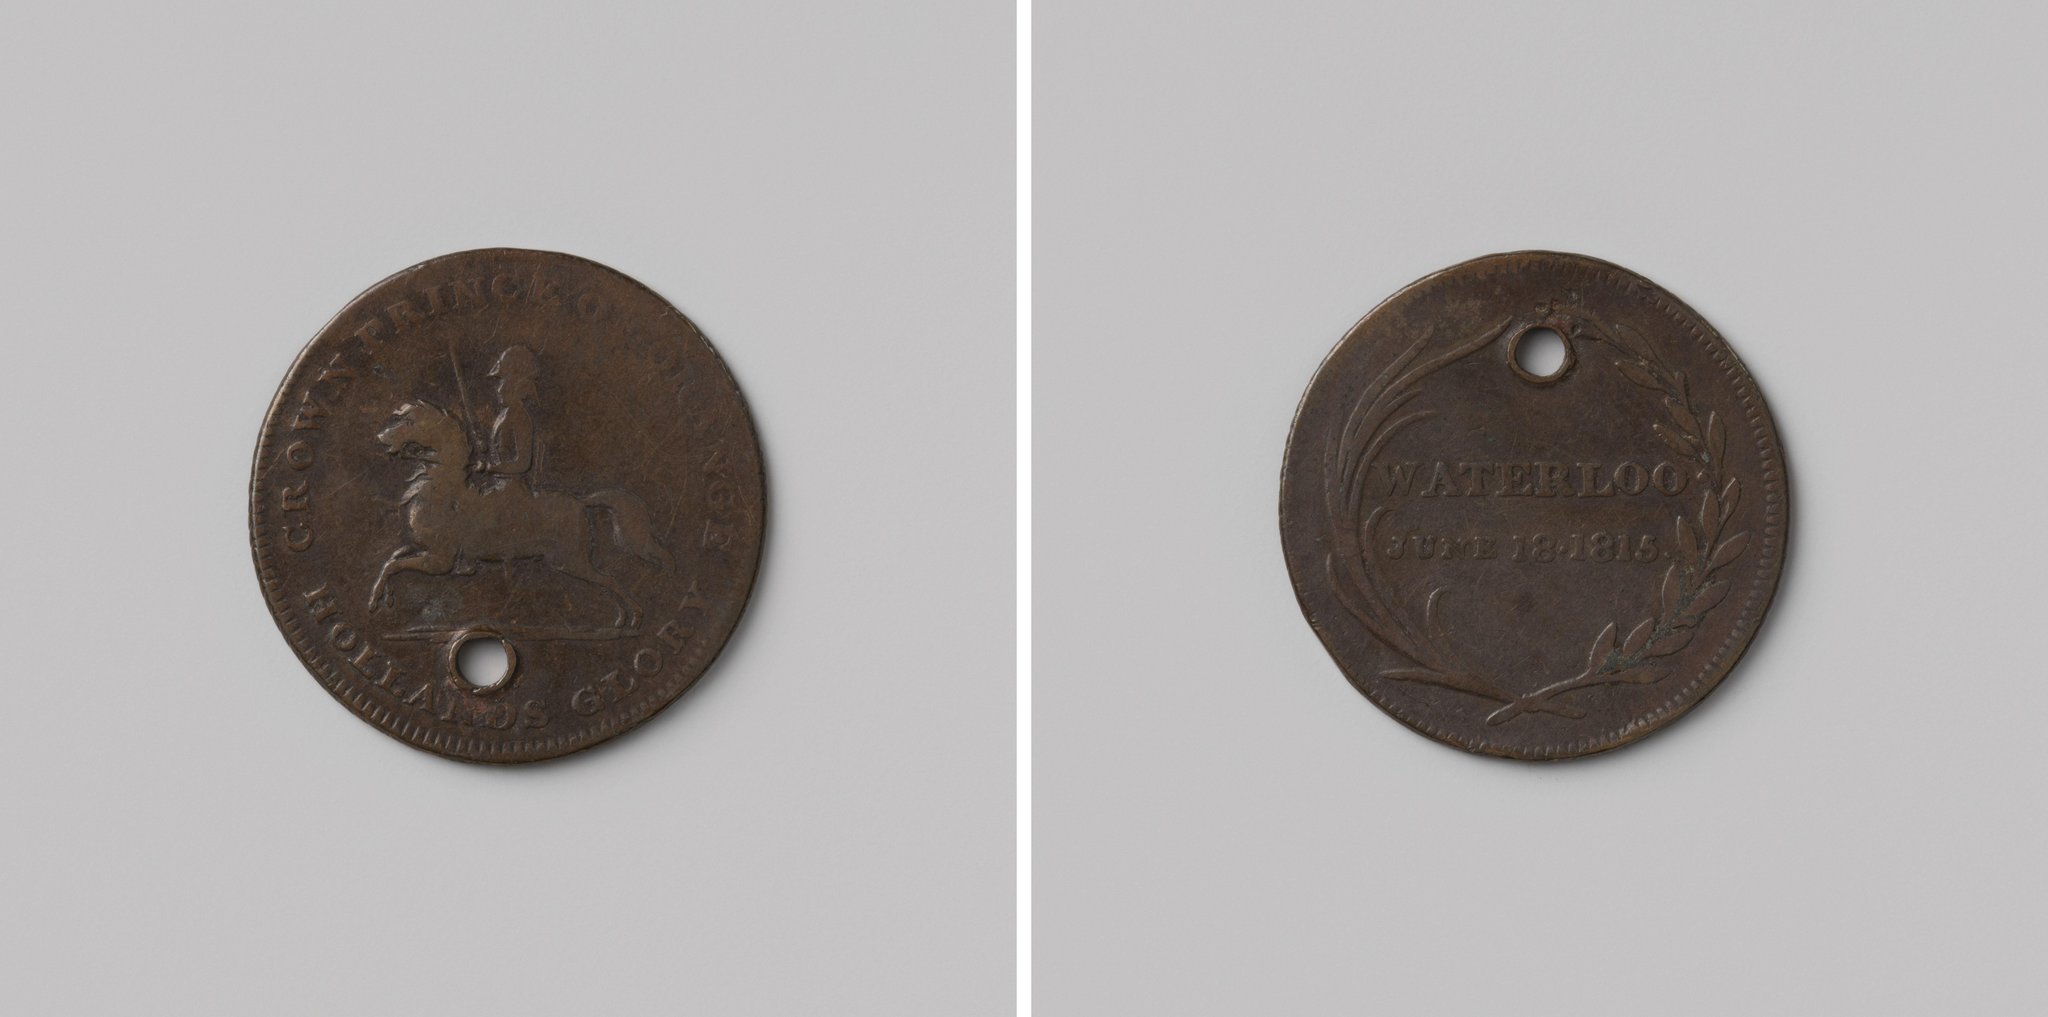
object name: jeton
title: Slag bij Waterloo, ter ere van Willem Frederik George Lodewijk, erfprins der Nederlanden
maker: Anonymous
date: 1815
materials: copper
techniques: striking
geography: england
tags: the hague, william ii of the netherlands, waterloo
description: Koperen penning met gat erin. Voorzijde: ruiter met getrokken zwaard binnen omschrift. Keerzijde: opschrift tussen palm- en olijftak